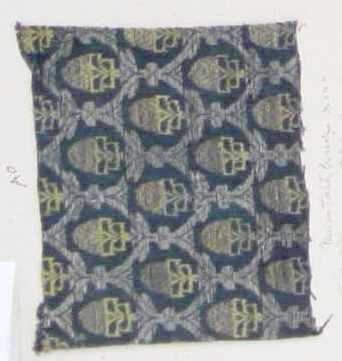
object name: textile fragment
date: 1601-1800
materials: silk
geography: iran